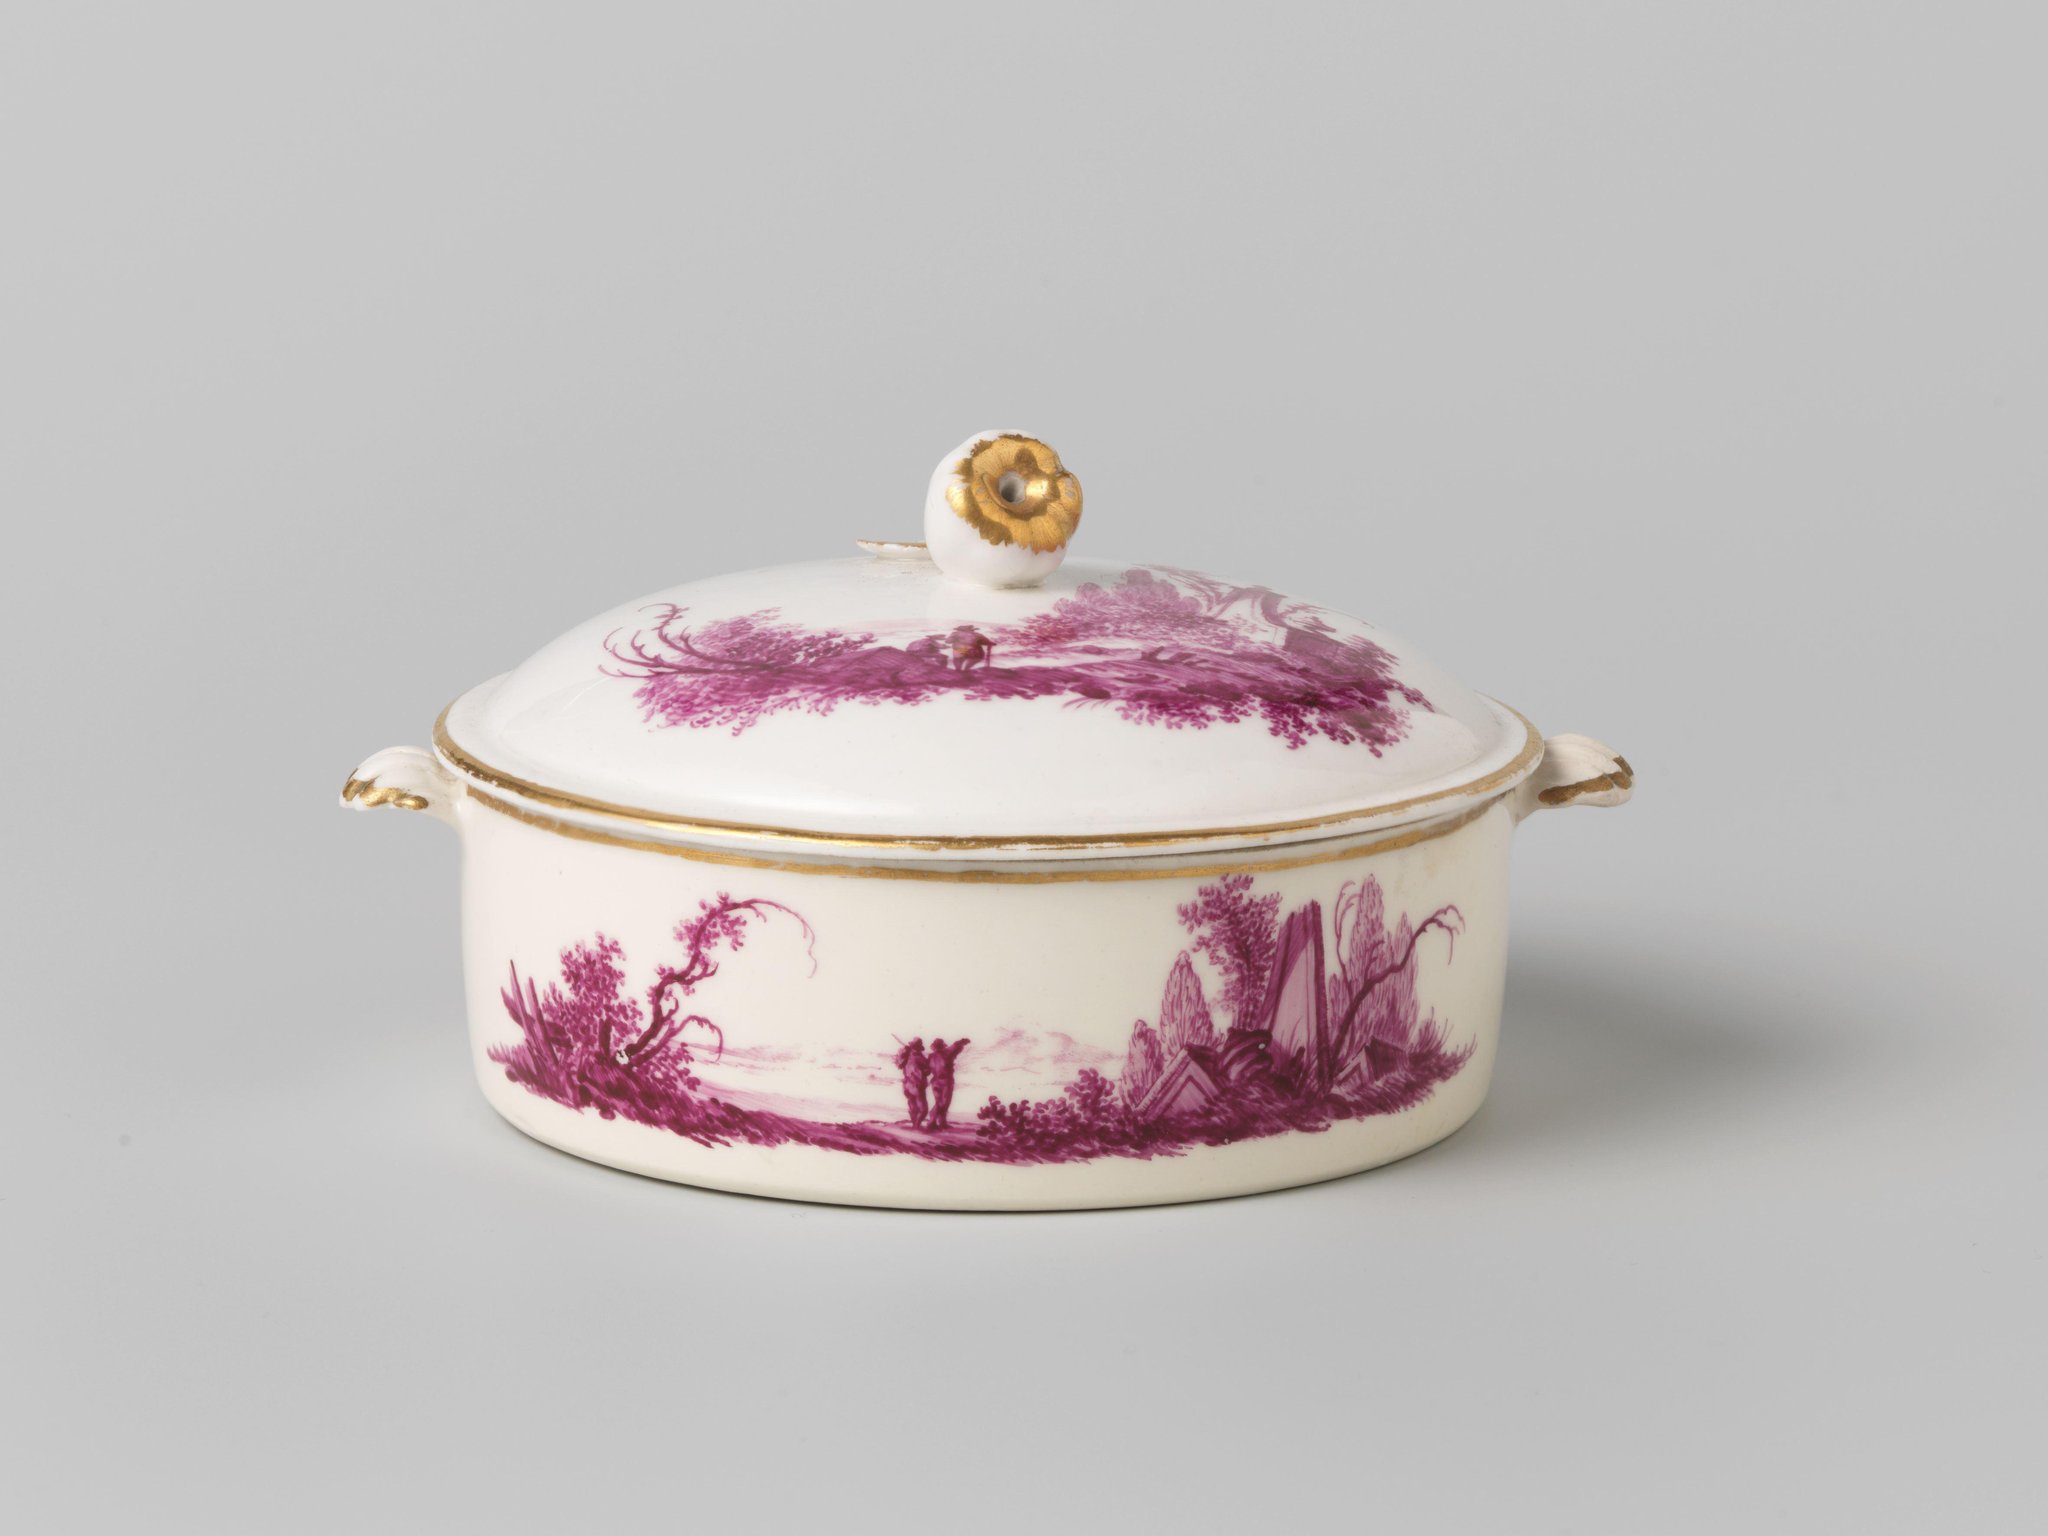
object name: butter dish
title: Botervloot, beschilderd met rivierlandschappen met figuren en monumenten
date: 1774-1778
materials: porcelain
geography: loosdrecht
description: Botervloot van porselein. Schelpvormige oren, vrucht met blaadje op het deksel als knop. Aan beide zijden en op het deksel beschilderd met rivierlandschappen met figuren en monumenten in bietenrood. Ornament in goud op de oren en dekselknop. Gouden bies langs mond- en dekselrand.